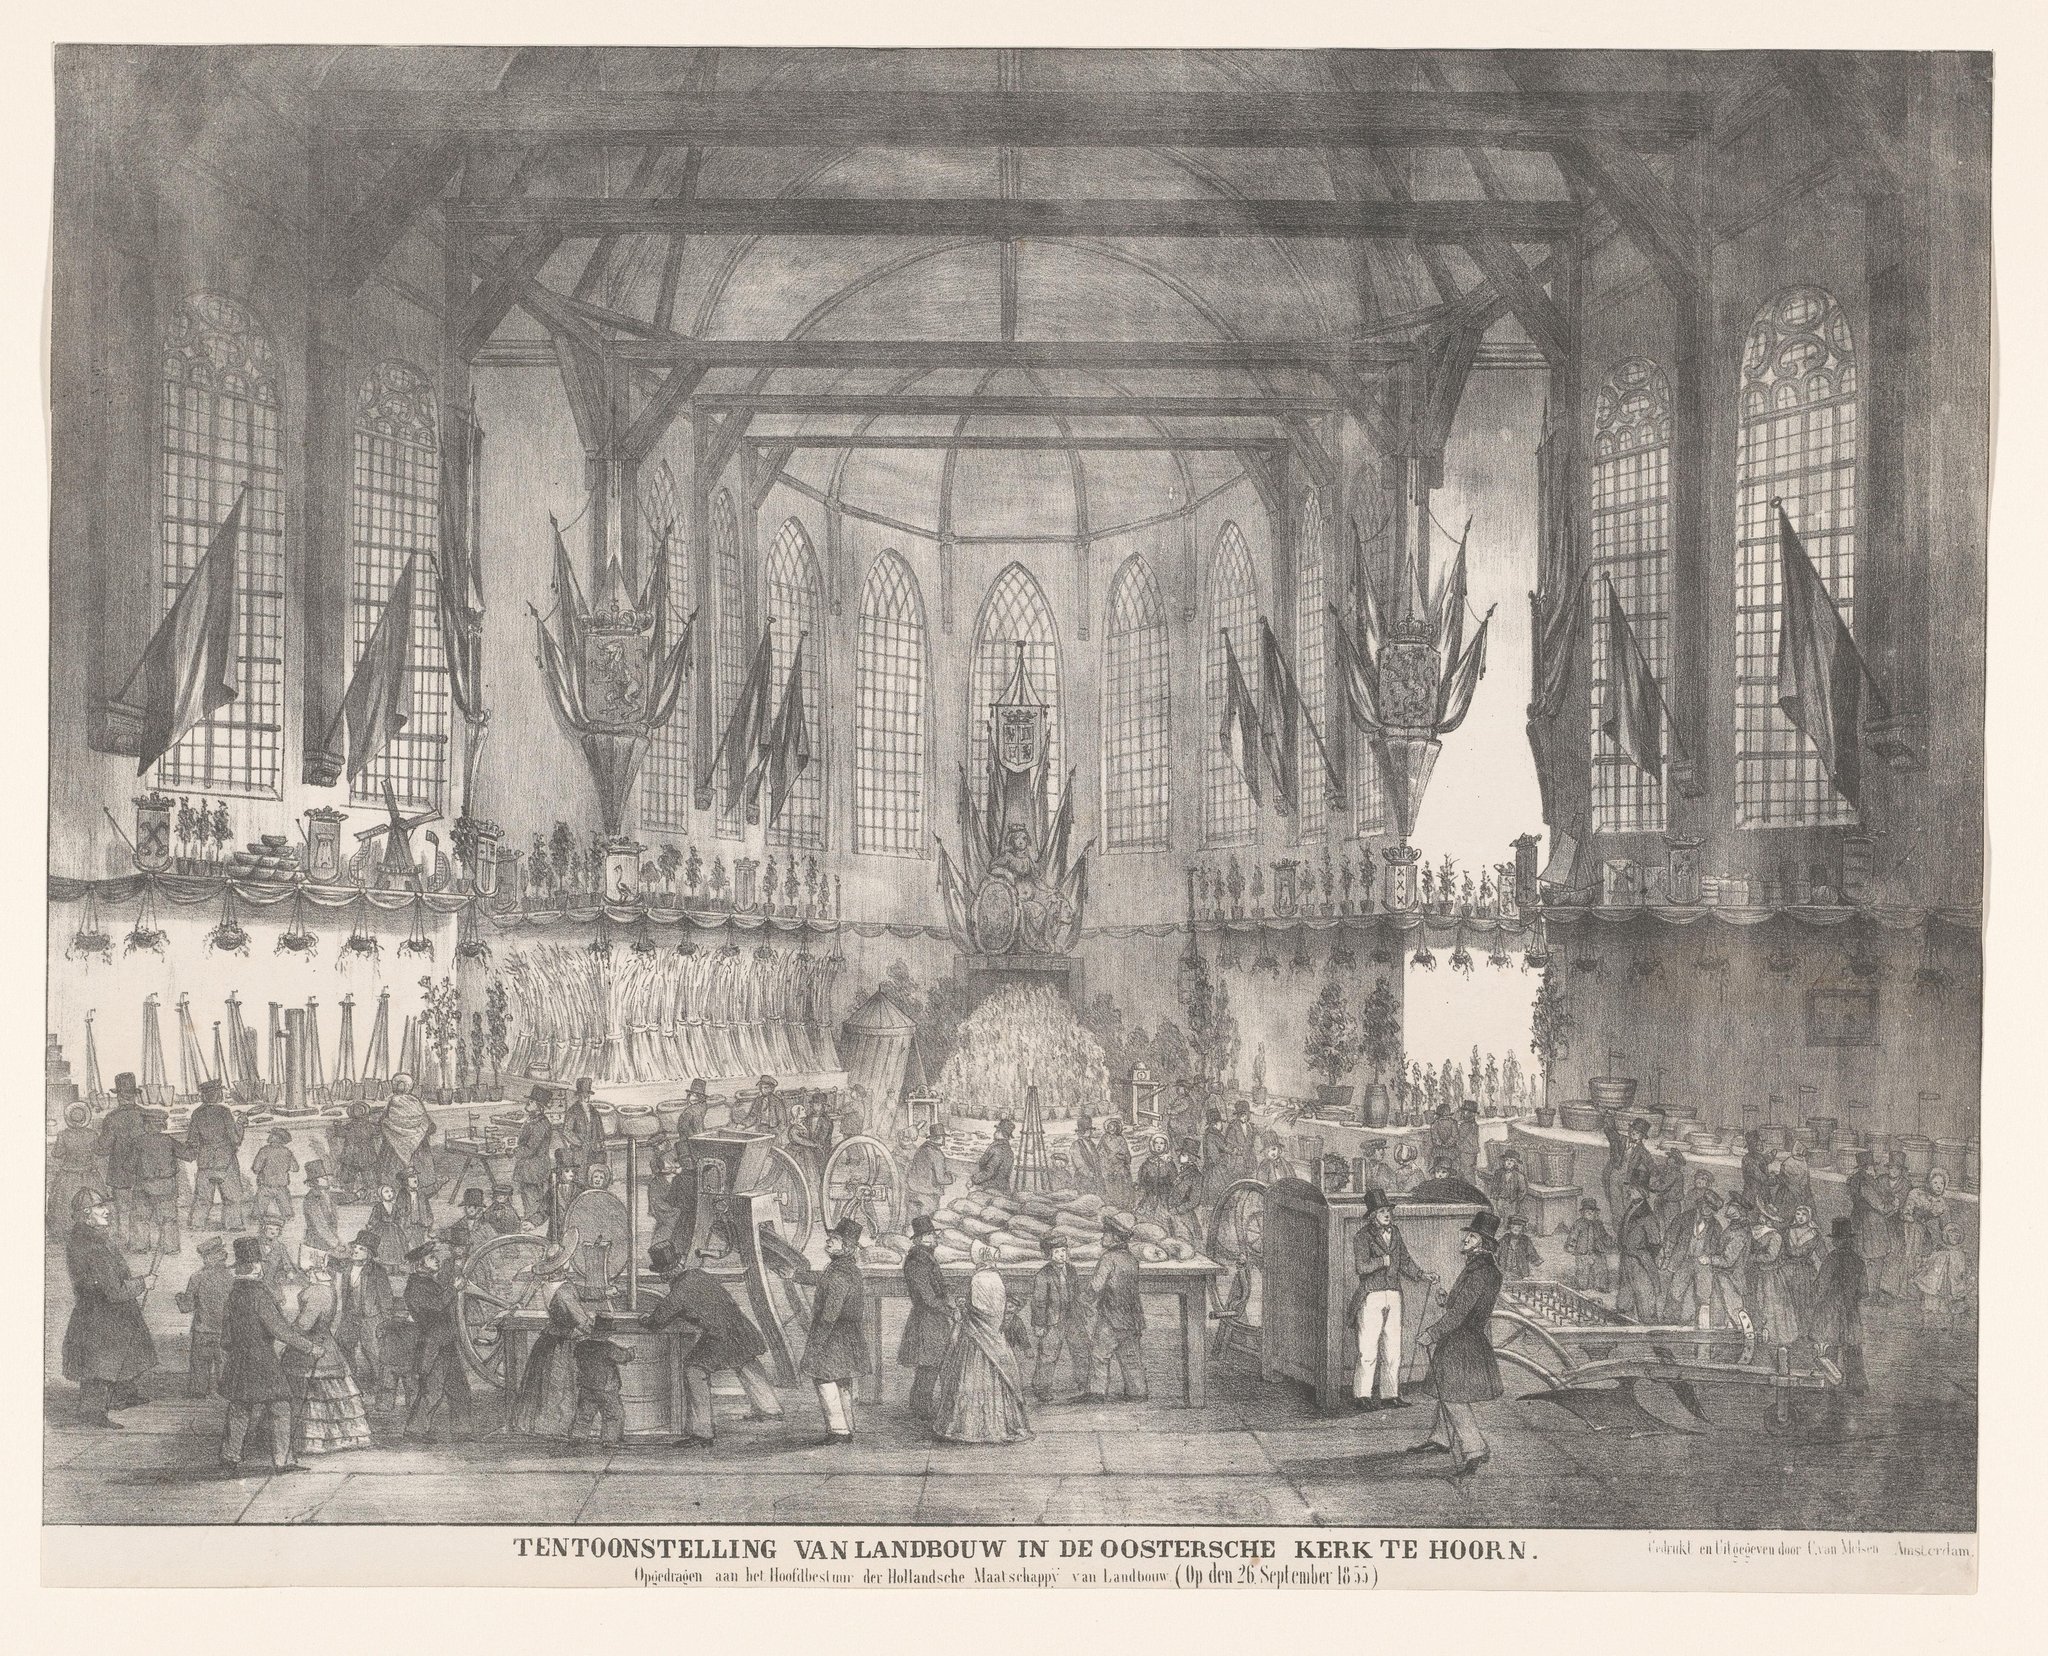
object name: print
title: Tentoonstelling van Landbouw in de Oostersche Kerk te Hoorn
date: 1855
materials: glass, paper, wood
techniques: lithograph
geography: amsterdam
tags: trade exhibition, industries fair, (annual) fair, trade fair, interior of church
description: Interieur van de Oosterkerk te Hoorn waarin de landbouwtentoonstelling wordt gehouden. Het kerkinterieur met vlaggen versierd en vol met mensen en (landbouw)voorwerpen. Opschrift; m.o.: "Opgedragen aan het Hoofdbestuur der Hollandsche Maatschappij van Landbouw (op den 26 September 1855)".